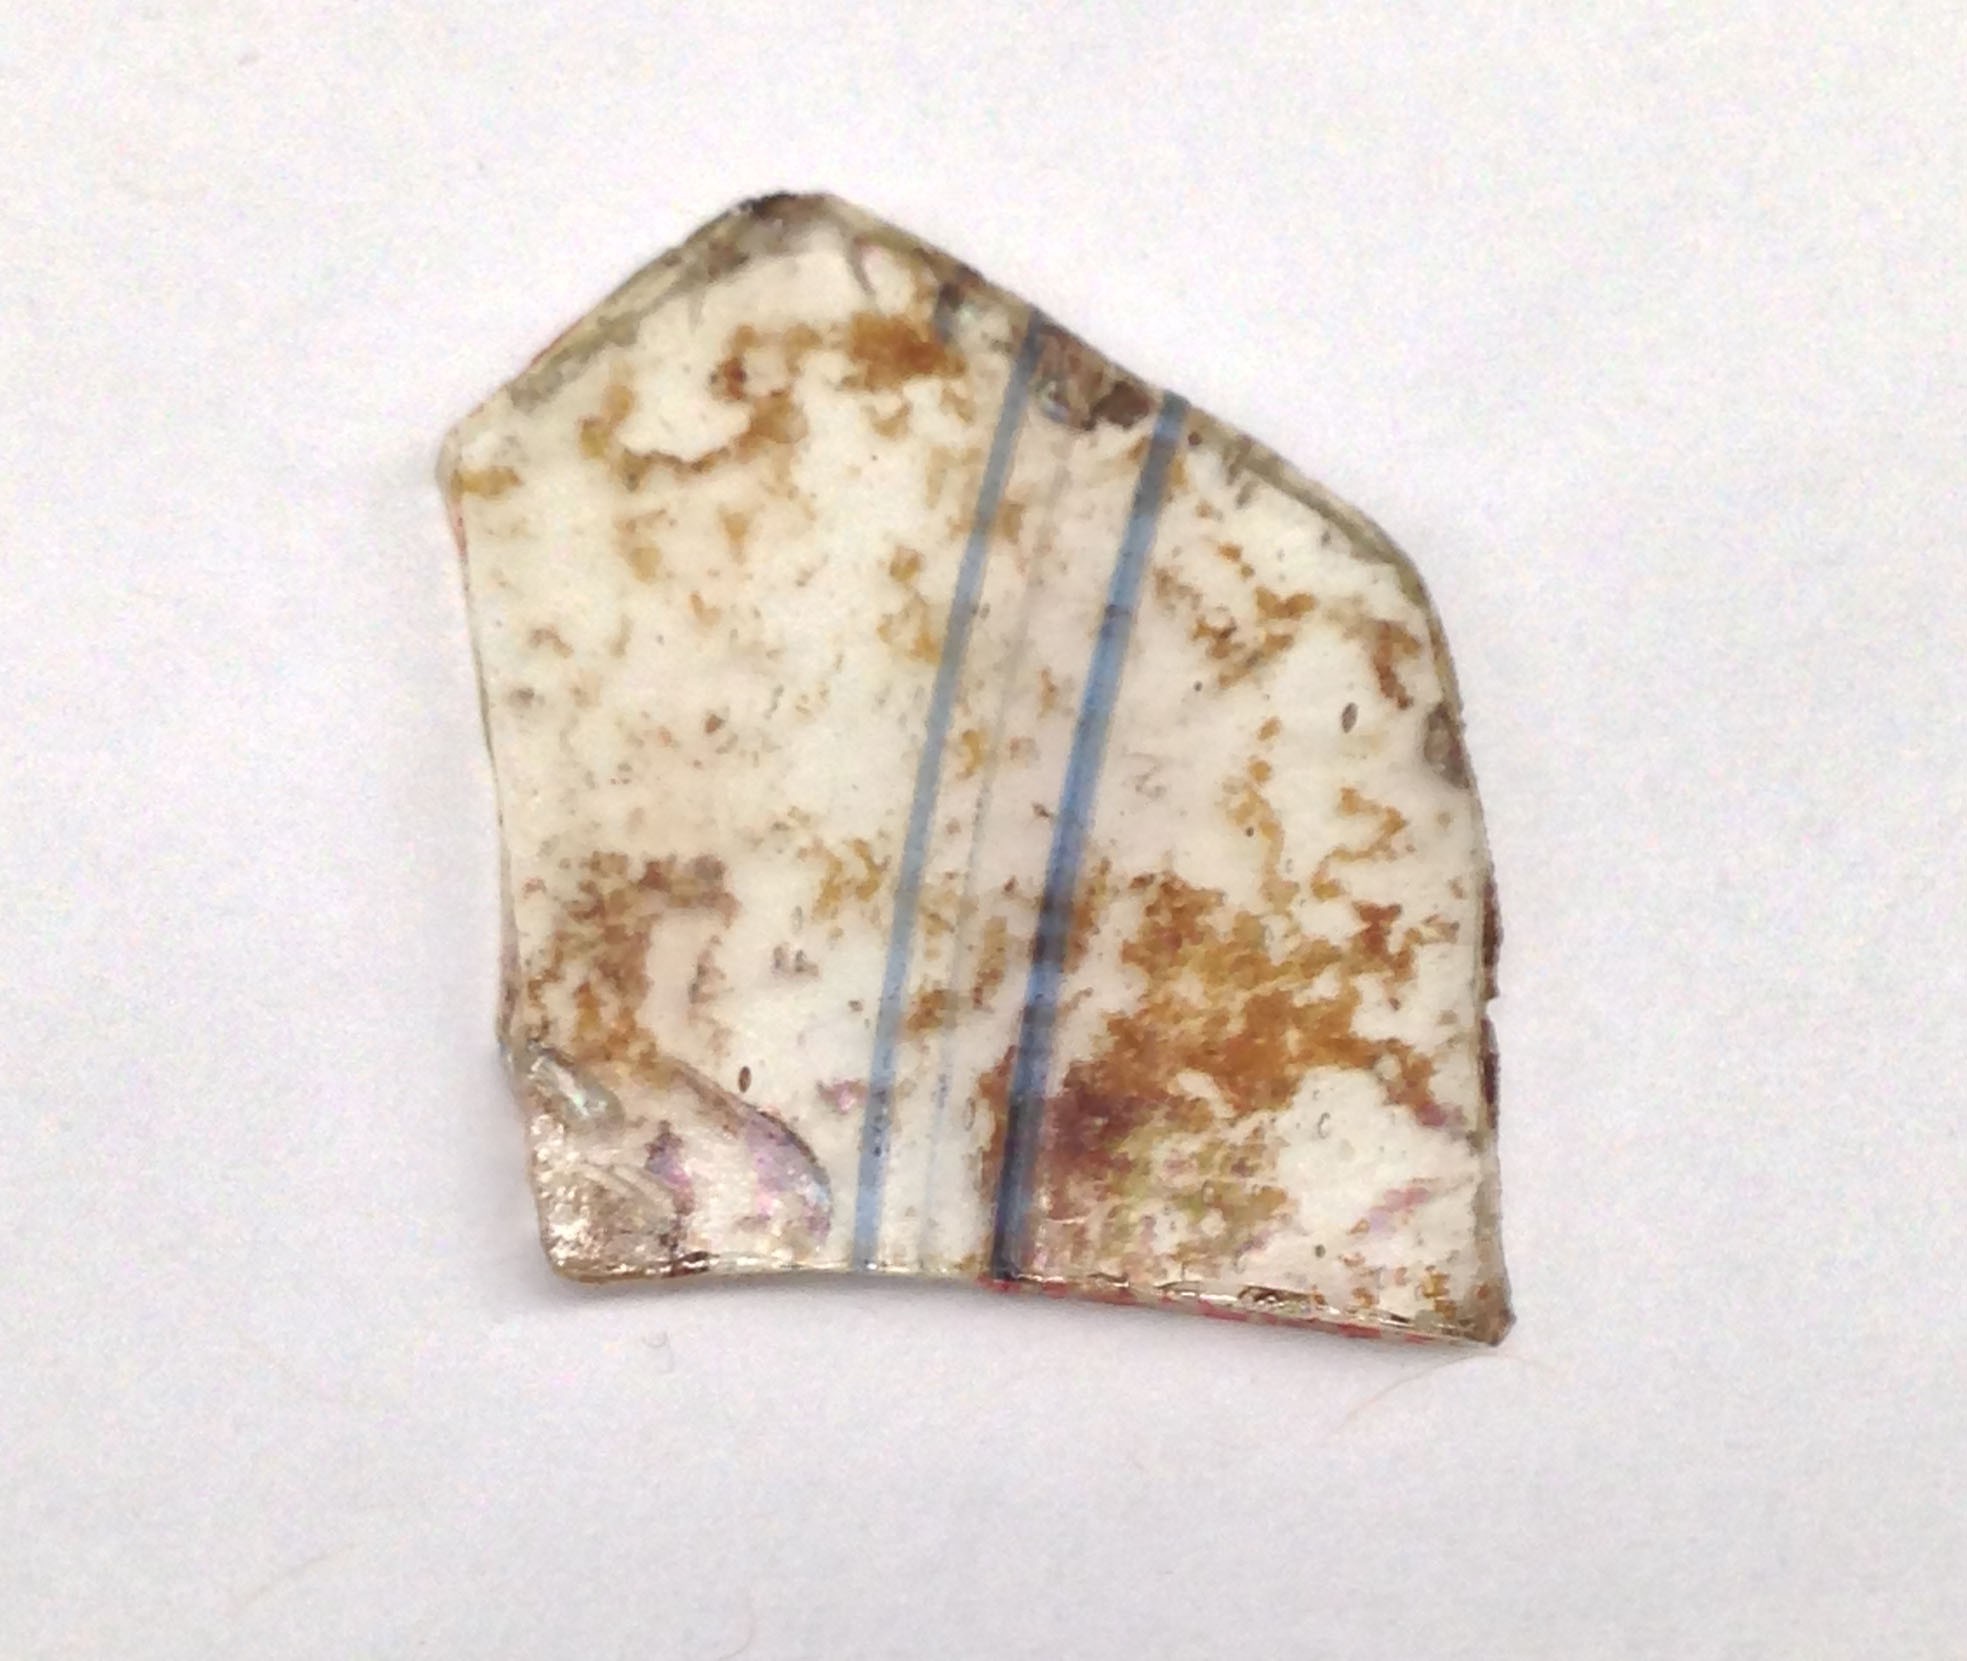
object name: fragment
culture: european or middle eastern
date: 1150-1250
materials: ceramic, glass